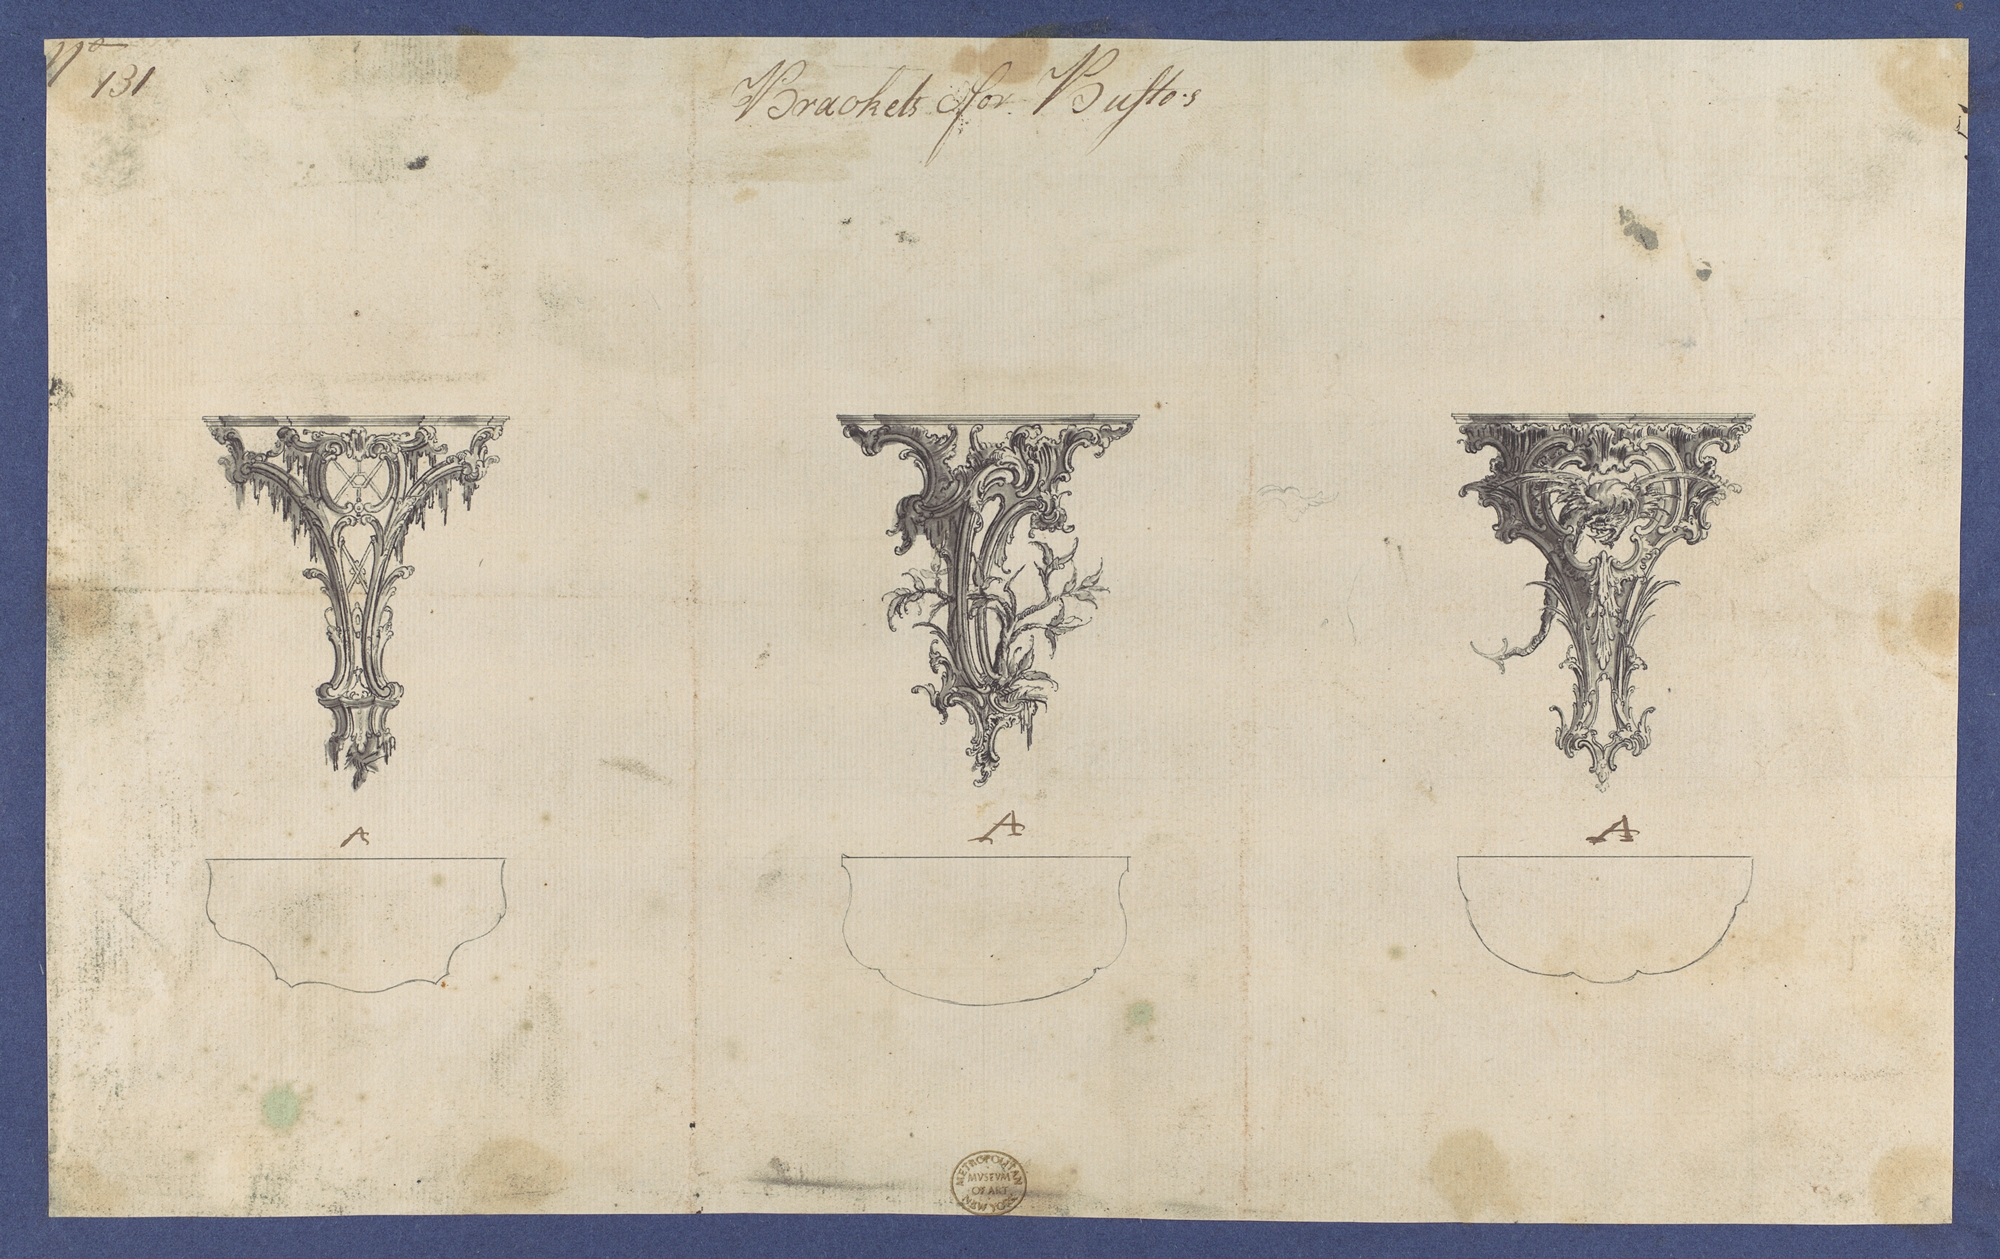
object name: drawing ornament architecture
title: Brackets for Bustos, in Chippendale Drawings, Vol. I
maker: thomas chippendale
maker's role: artist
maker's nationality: british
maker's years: 1718-1779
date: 1754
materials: ink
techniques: wash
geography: london